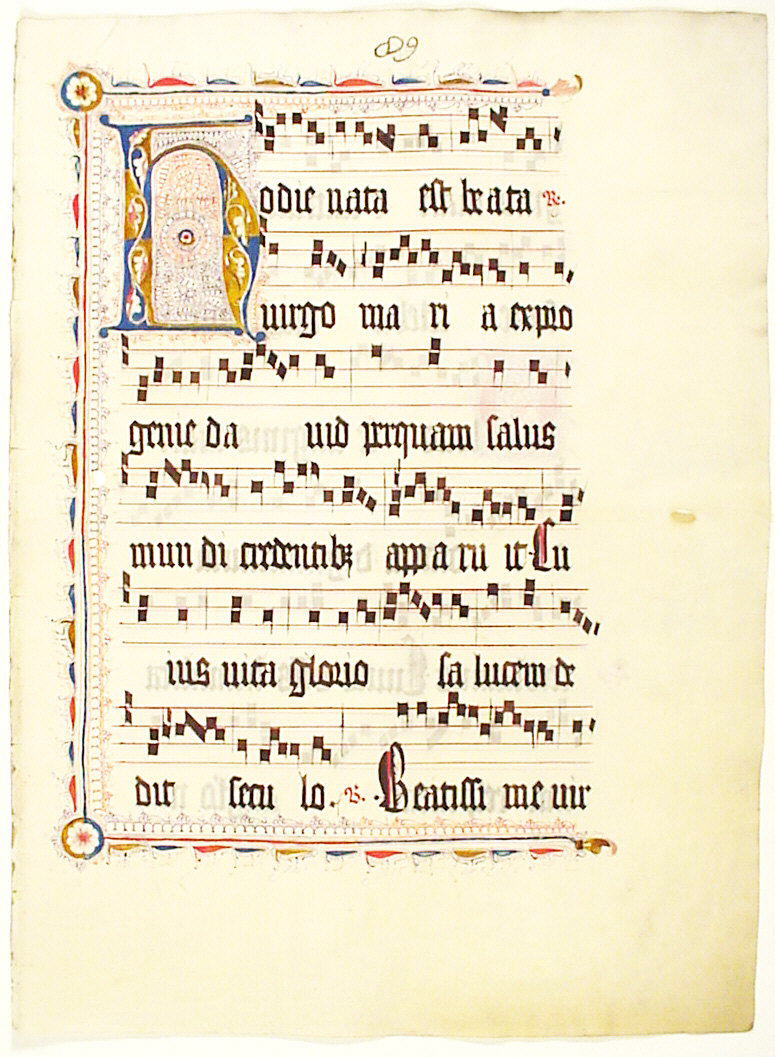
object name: antiphonary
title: Manuscript Leaf with Initial H, from an Antiphonary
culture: german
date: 1426-1450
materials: ink, metal leaf, parchment, paint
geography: germany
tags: music